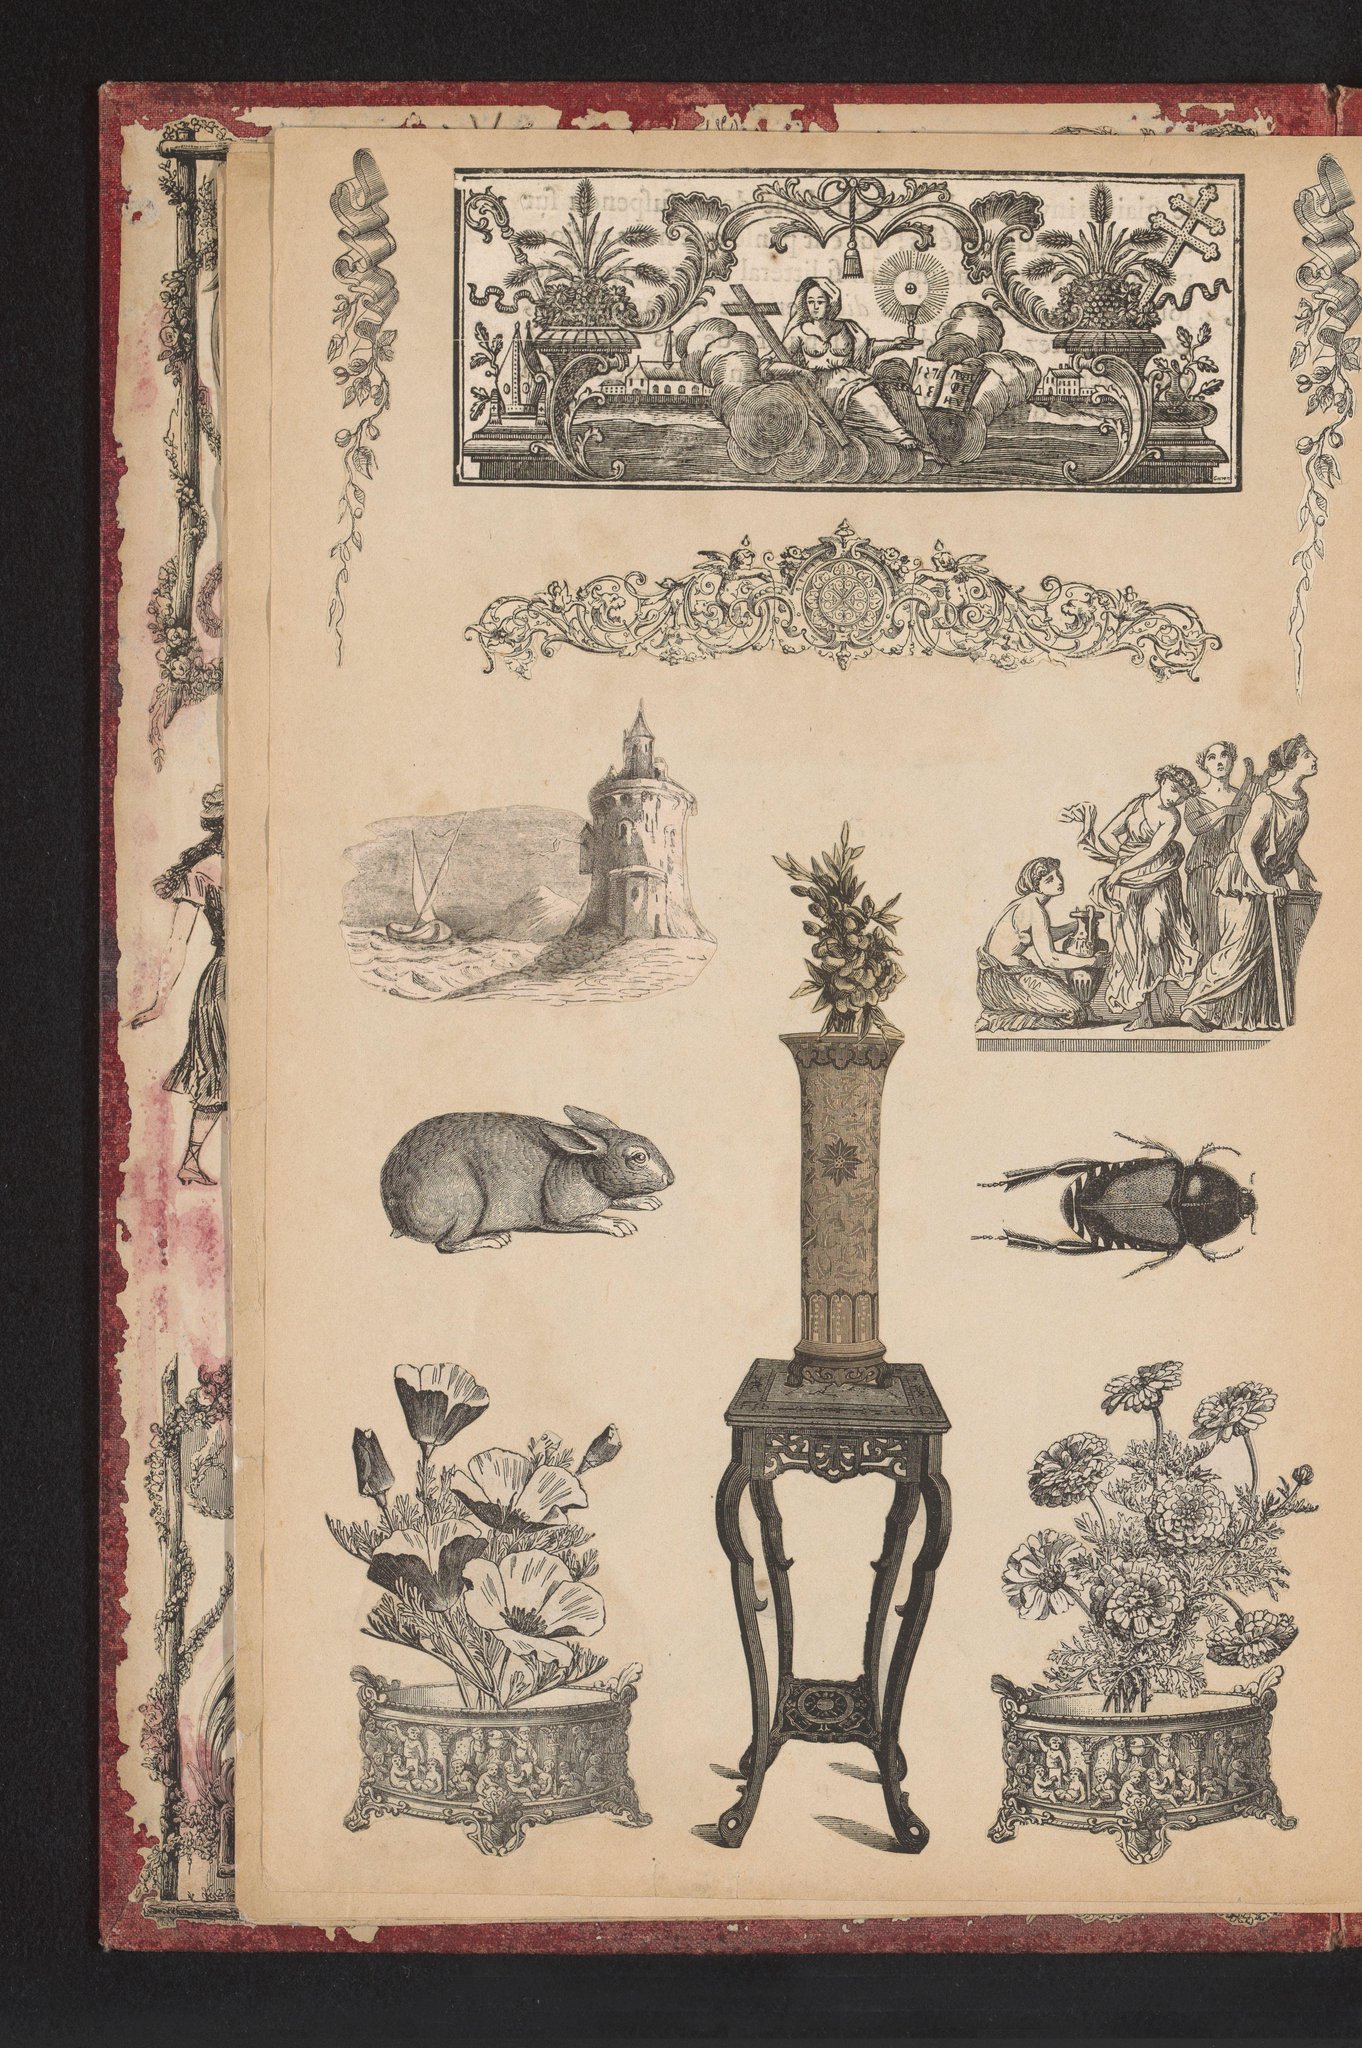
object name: collage visual work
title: Collage van uitgeknipte prenten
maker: Anonymous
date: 1870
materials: paper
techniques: engraving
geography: paris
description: Collage van uitgeknipte prenten. Onderdeel van een album met 32 bladen, aan beide zijden beplakt met uitgeknipte prenten, vermoedelijk afkomstig uit 19e-eeuwse tijdschiften.